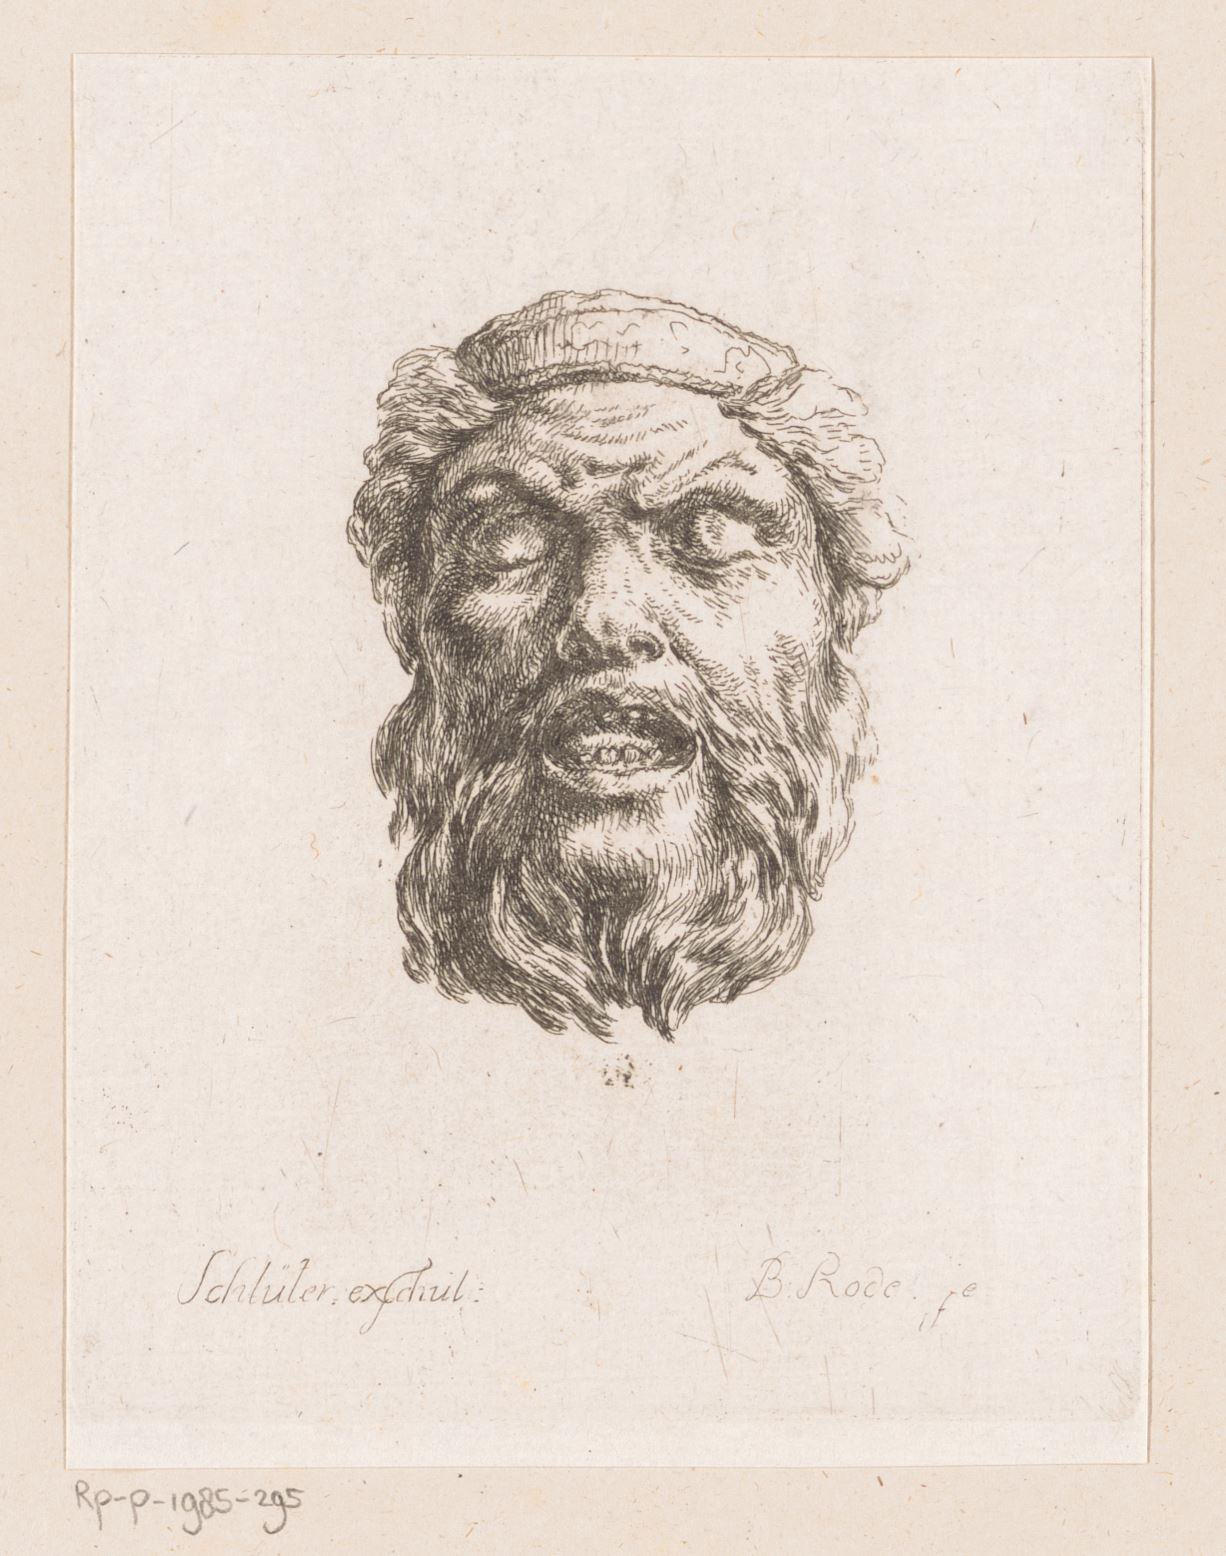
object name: print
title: Mannenkop met gesloten ogen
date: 1759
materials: paper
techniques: etching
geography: berlin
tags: face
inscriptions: collector's mark: Lugt 2760, collector's mark: Lugt 2228